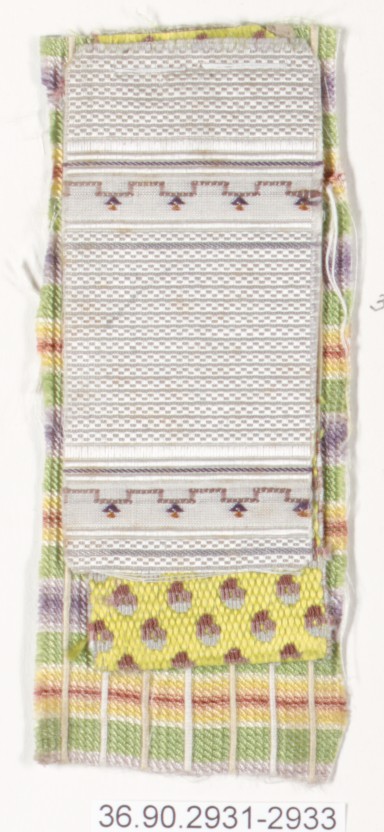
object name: piece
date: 1801-1900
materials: silk